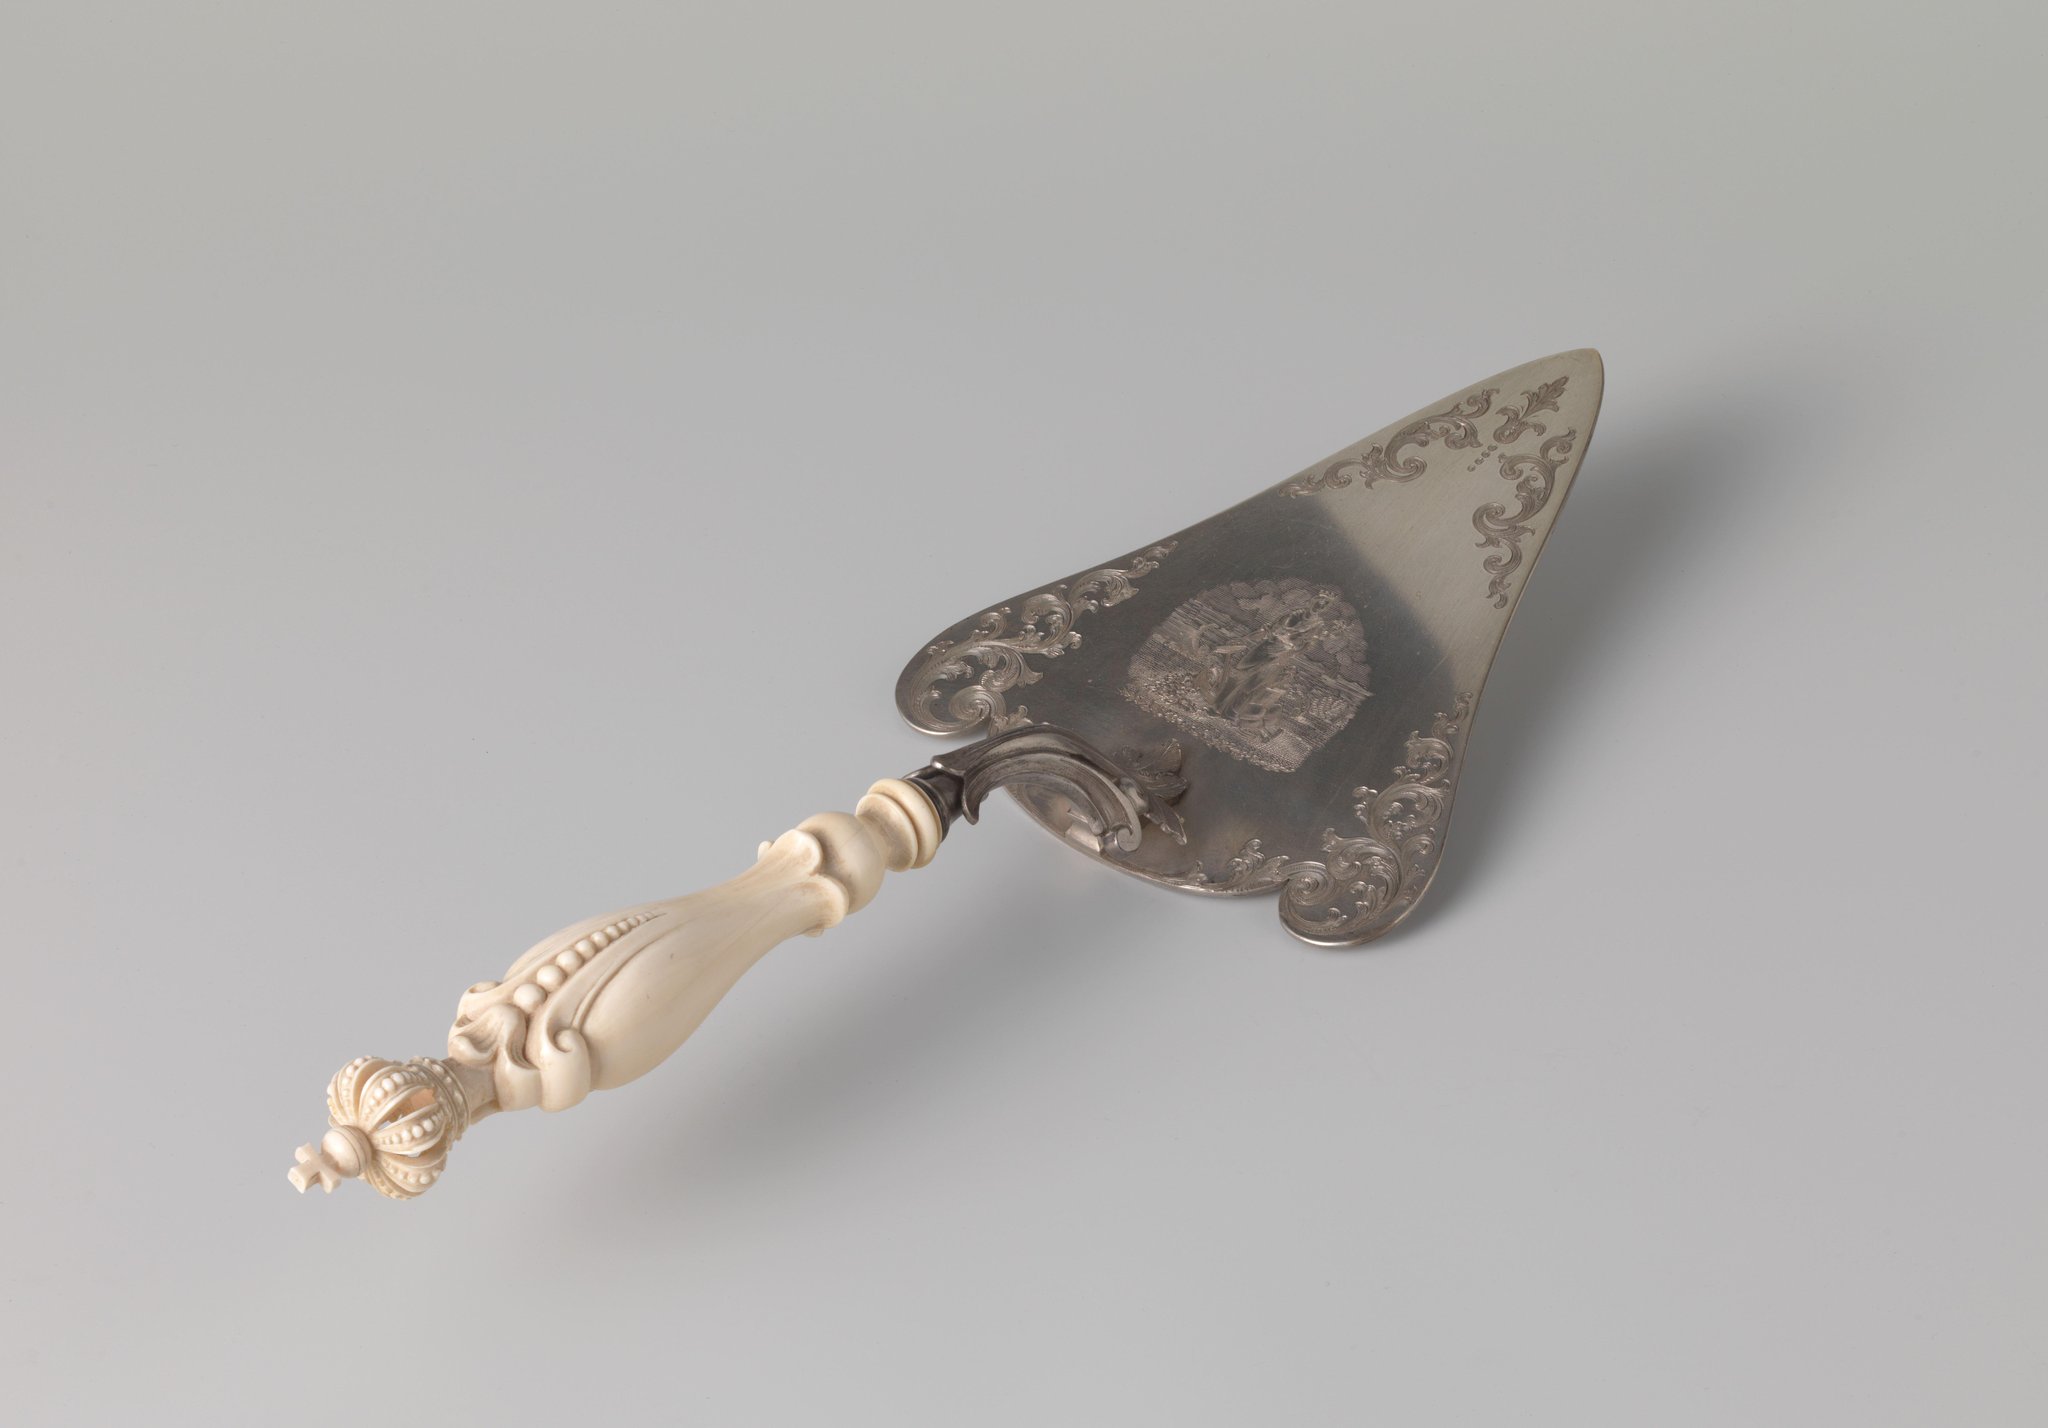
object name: trowel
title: Troffel gebruikt door koning Willem III bij het leggen der gedenksteen der Oranjesluizen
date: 1870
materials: ivory, silver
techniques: cutting, engraving, forging, screwed, striking, turning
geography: amsterdam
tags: brussels, willem iii (koning der nederlanden)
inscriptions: date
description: Zilveren troffel met ivoren steel. Steel sierlijk uitgesneden, voorzien van plantmotieven, met als knop ajour gesneden kroon met kruis. Het zilver gedeelte van de steel in de vorm van bladeren, onder gesteund door een vierkante stang, met een sokkeltje op het plat bevestigd. Het plat sierlijk van vorm, met in het midden de gegraveerde voorstelling van gekroonde staande vrouw met Hermesstaf in de hand, ander steunend op anker. Op de keerzijde opschrift links: klimmende leeuw met jaarletter L. Keerzijde rechts datering etc.